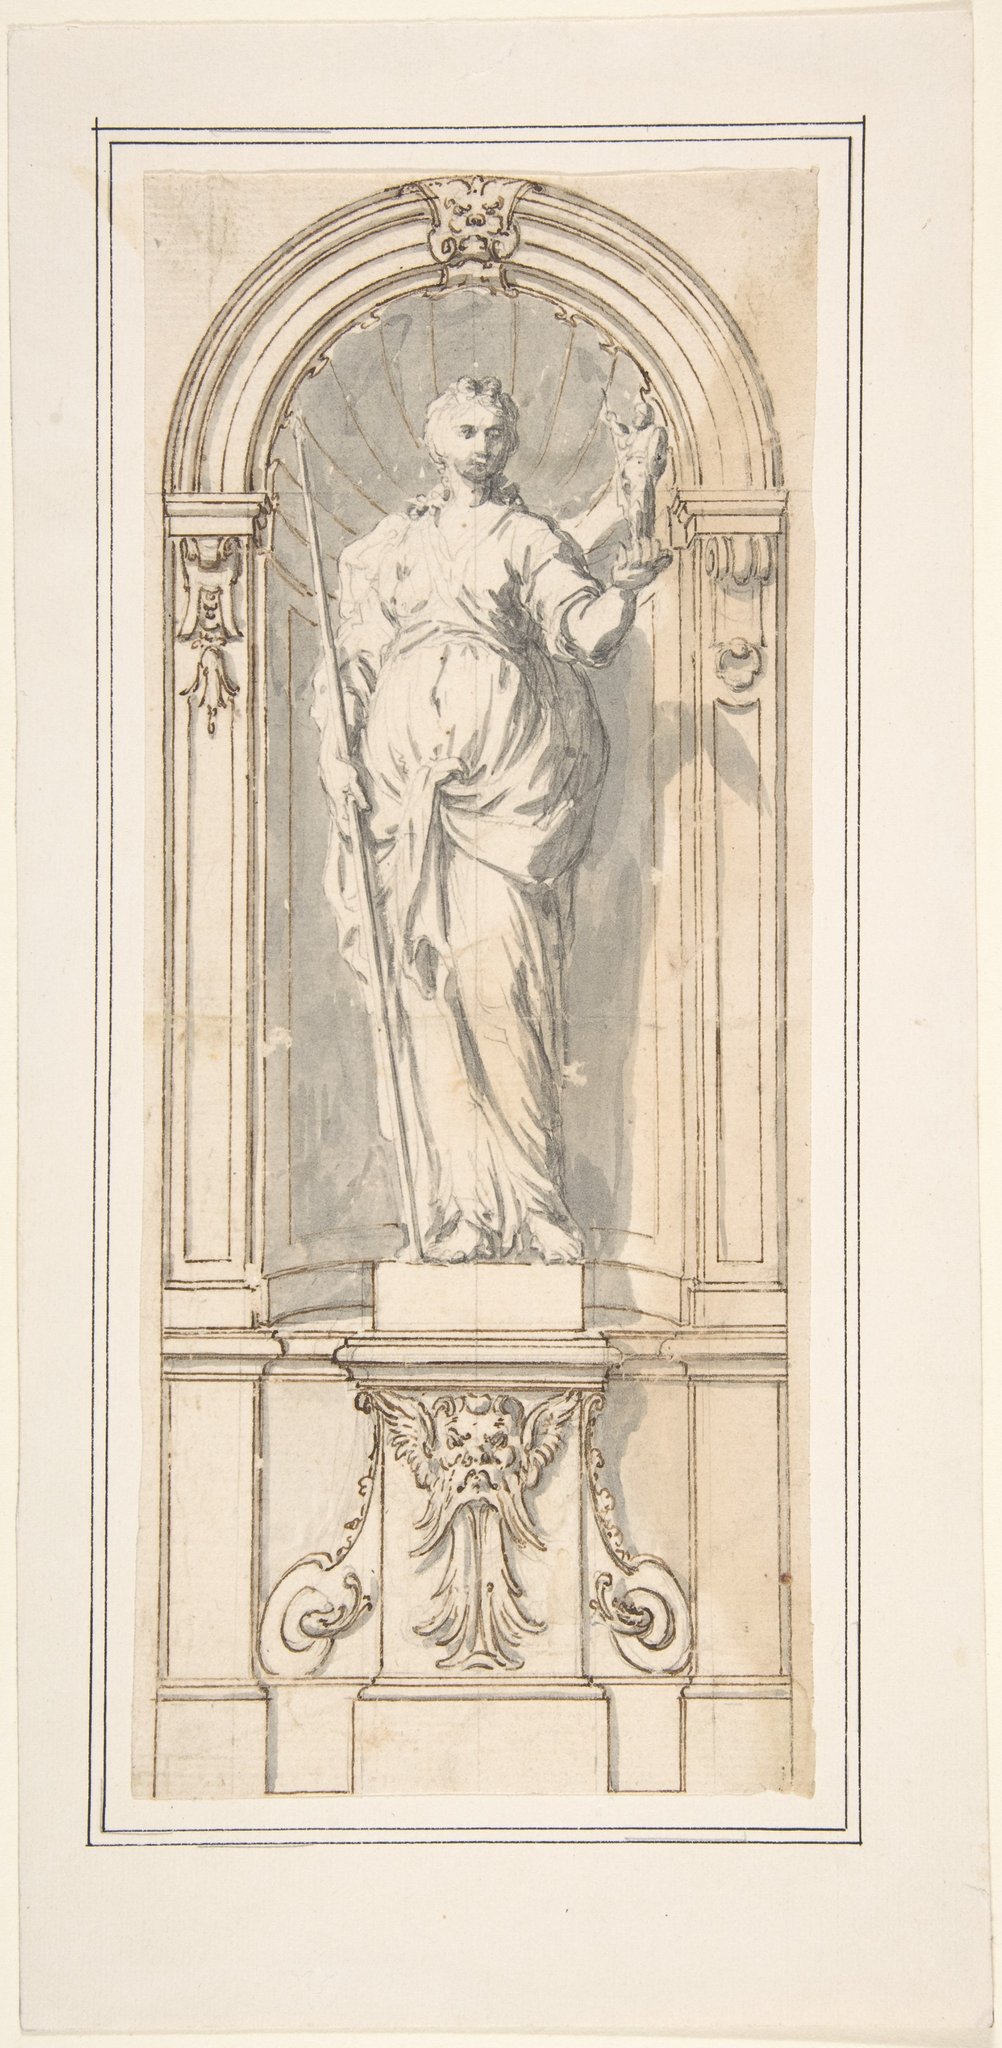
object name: drawing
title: Classical Niche with Figure of a Woman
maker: anonymous, 18th century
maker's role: artist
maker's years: 1700-1800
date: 1701-1800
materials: chalk, ink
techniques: brush, pen, wash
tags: sculpture,women